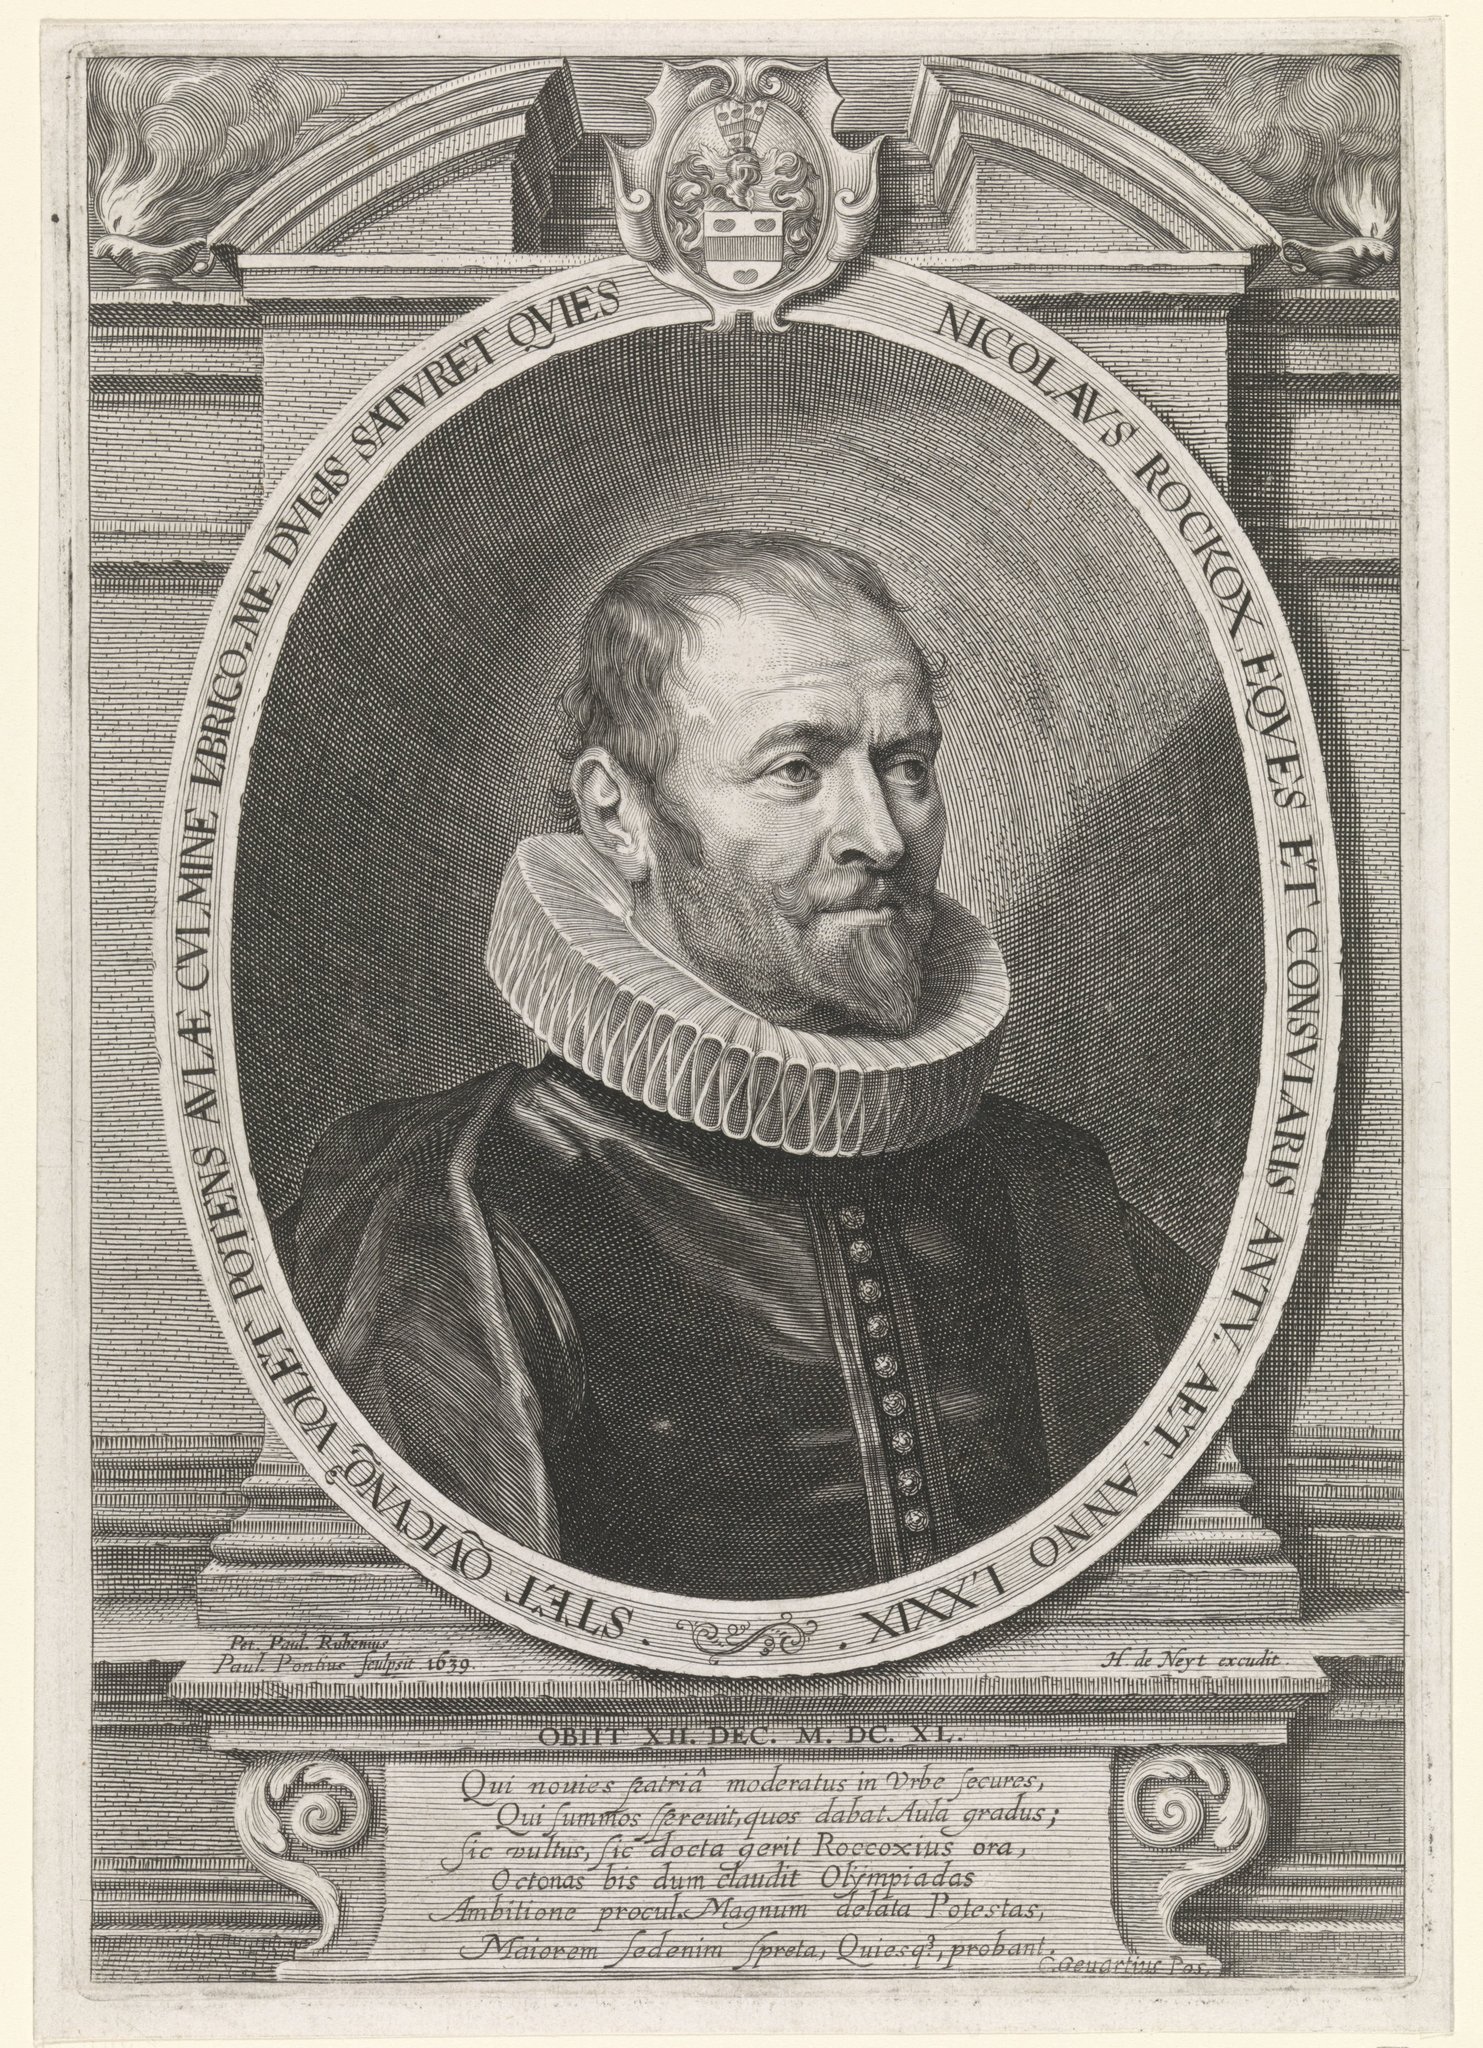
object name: print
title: Portret van Nicolaas Rockox jr., op 79-jarige leeftijd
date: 1639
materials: paper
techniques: engraving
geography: antwerp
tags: antwerp, nikolaas rockox, armorial bearing, heraldry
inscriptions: collector's mark: Lugt 240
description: Portret van Nicolaas Rockox jr., burgemeester van Antwerpen, bekroond met zijn wapenschild. In het kader op de piëdestal een zesregelig lofdicht in het Latijn.